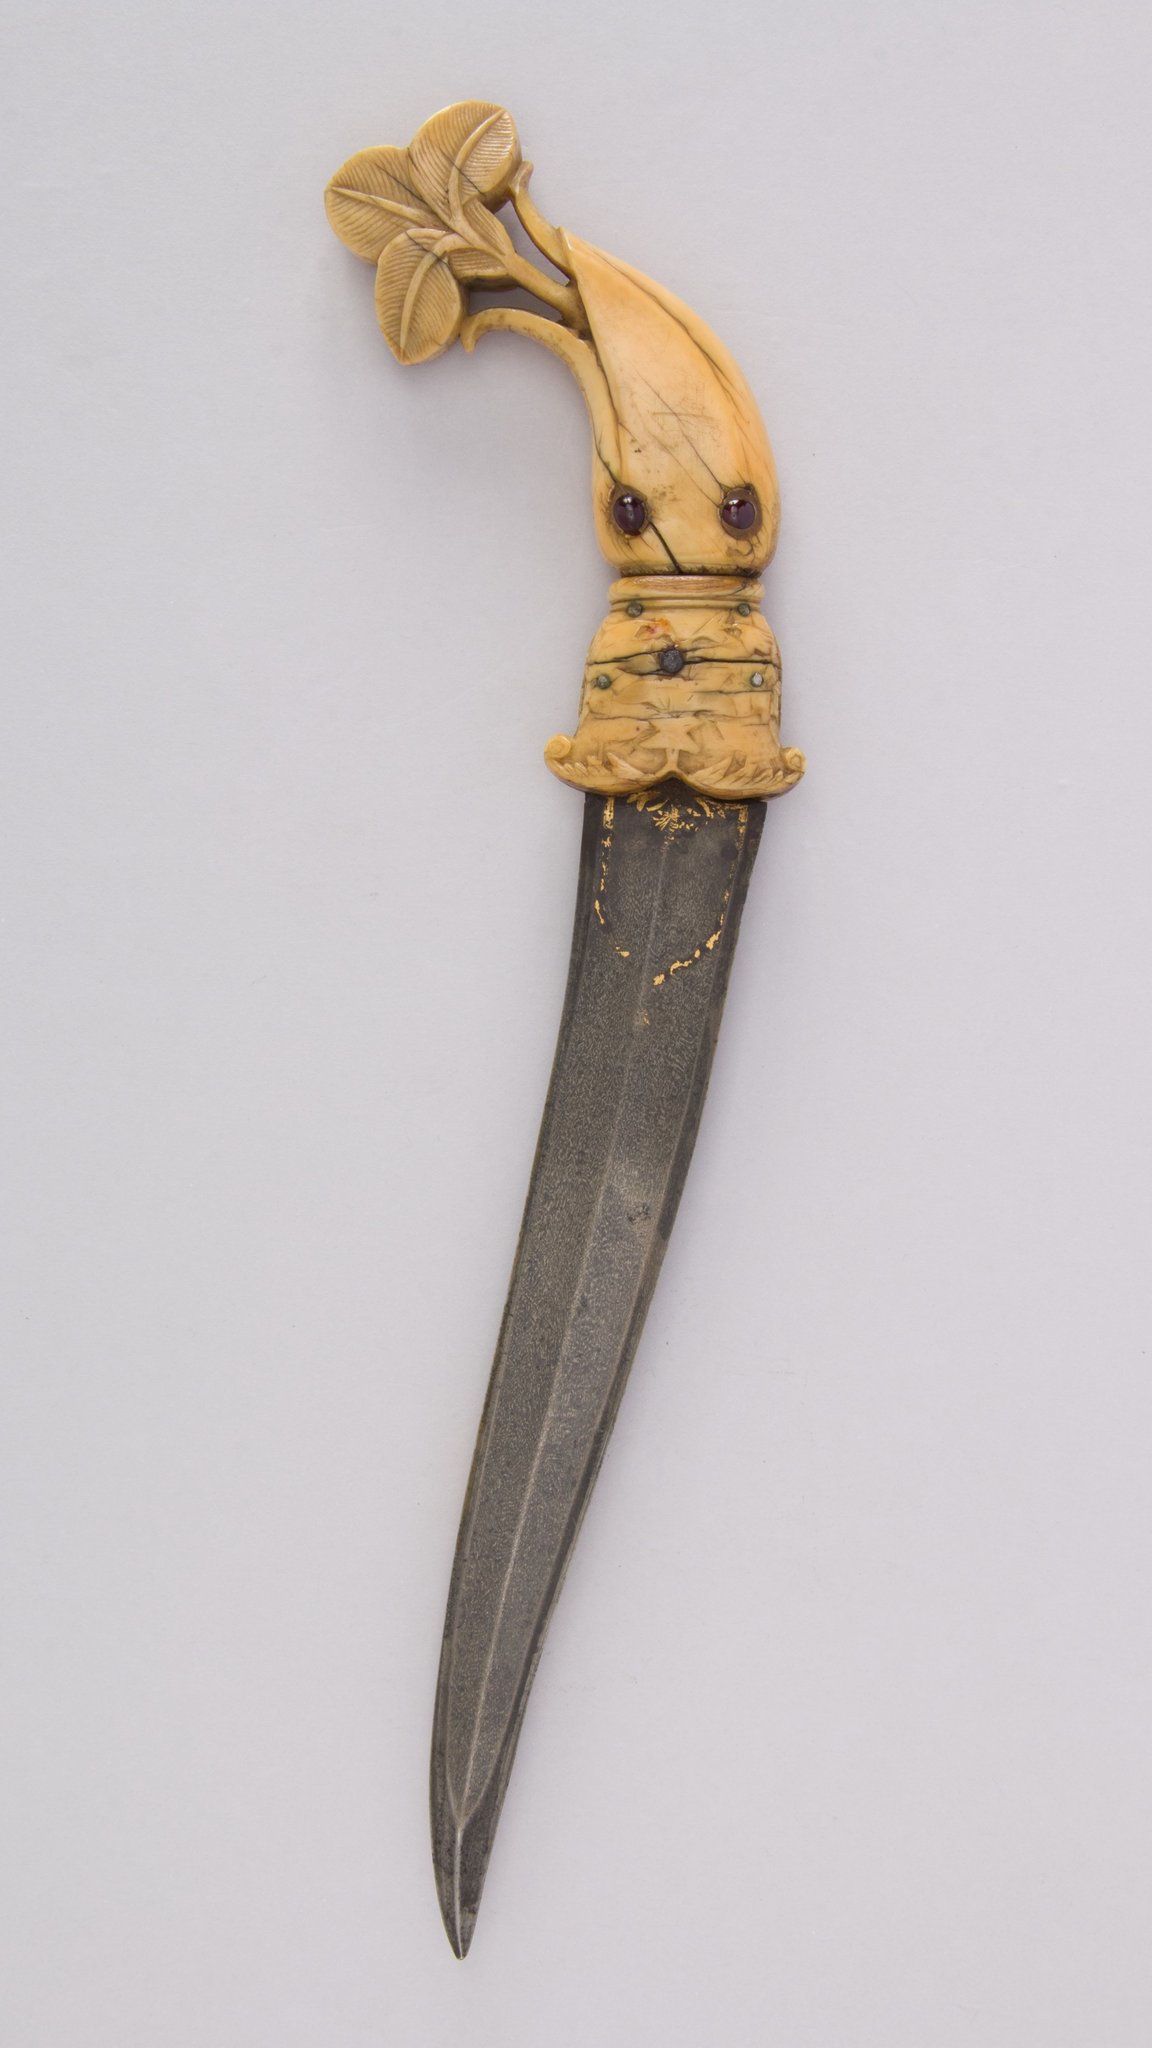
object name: dagger khanjar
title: Dagger (Khanjar)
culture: indian, mughal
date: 1634-1666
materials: gold, ivory, steel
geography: india